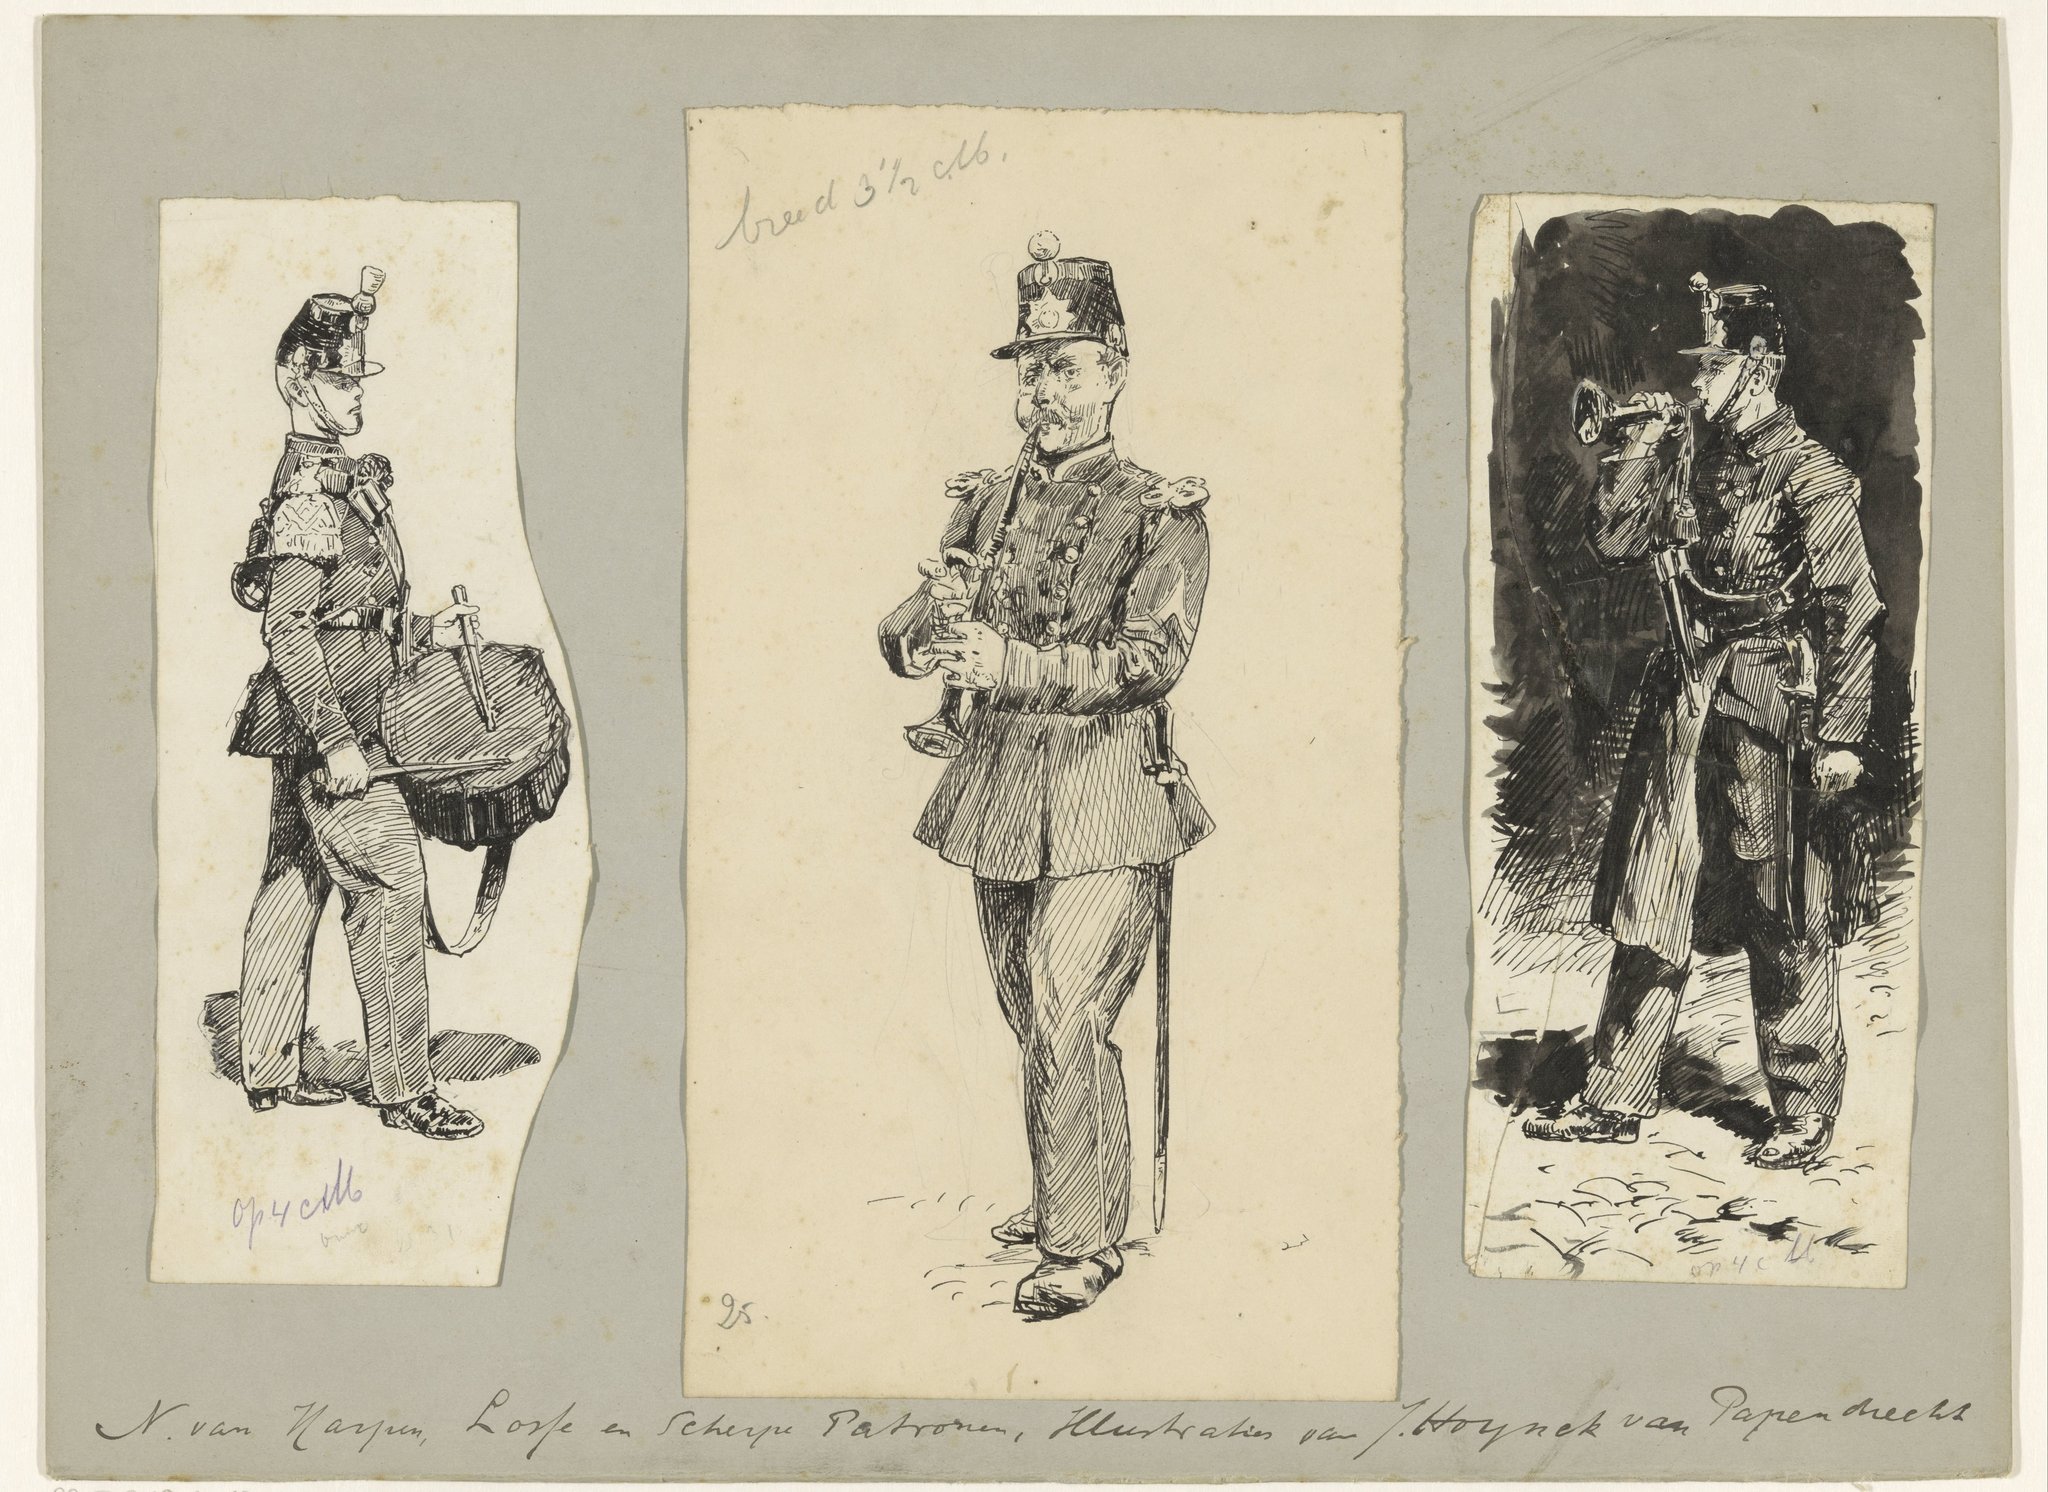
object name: boekillustratie ontwerp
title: Militairen met een trommel en blaasinstrumenten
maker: jan hoynck van papendrecht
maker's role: draughtsman, painter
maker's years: 1858-1933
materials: paint, ink, paper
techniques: brush, pen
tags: horn, trumpet, cornet, trombone, tuba, drum (musical instrument), the soldier; the soldier's life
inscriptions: annotation: ‘N. van Harpen, Losse en Scherpe Patronen, Illustraties van J. Hoynck van Papendrecht’, collector's mark: Lugt 2228, :, number: ‘25.’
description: Ontwerp voor: Harpen, N. van. Losse en scherpe patronen. Amsterdam: Veen, 1889.